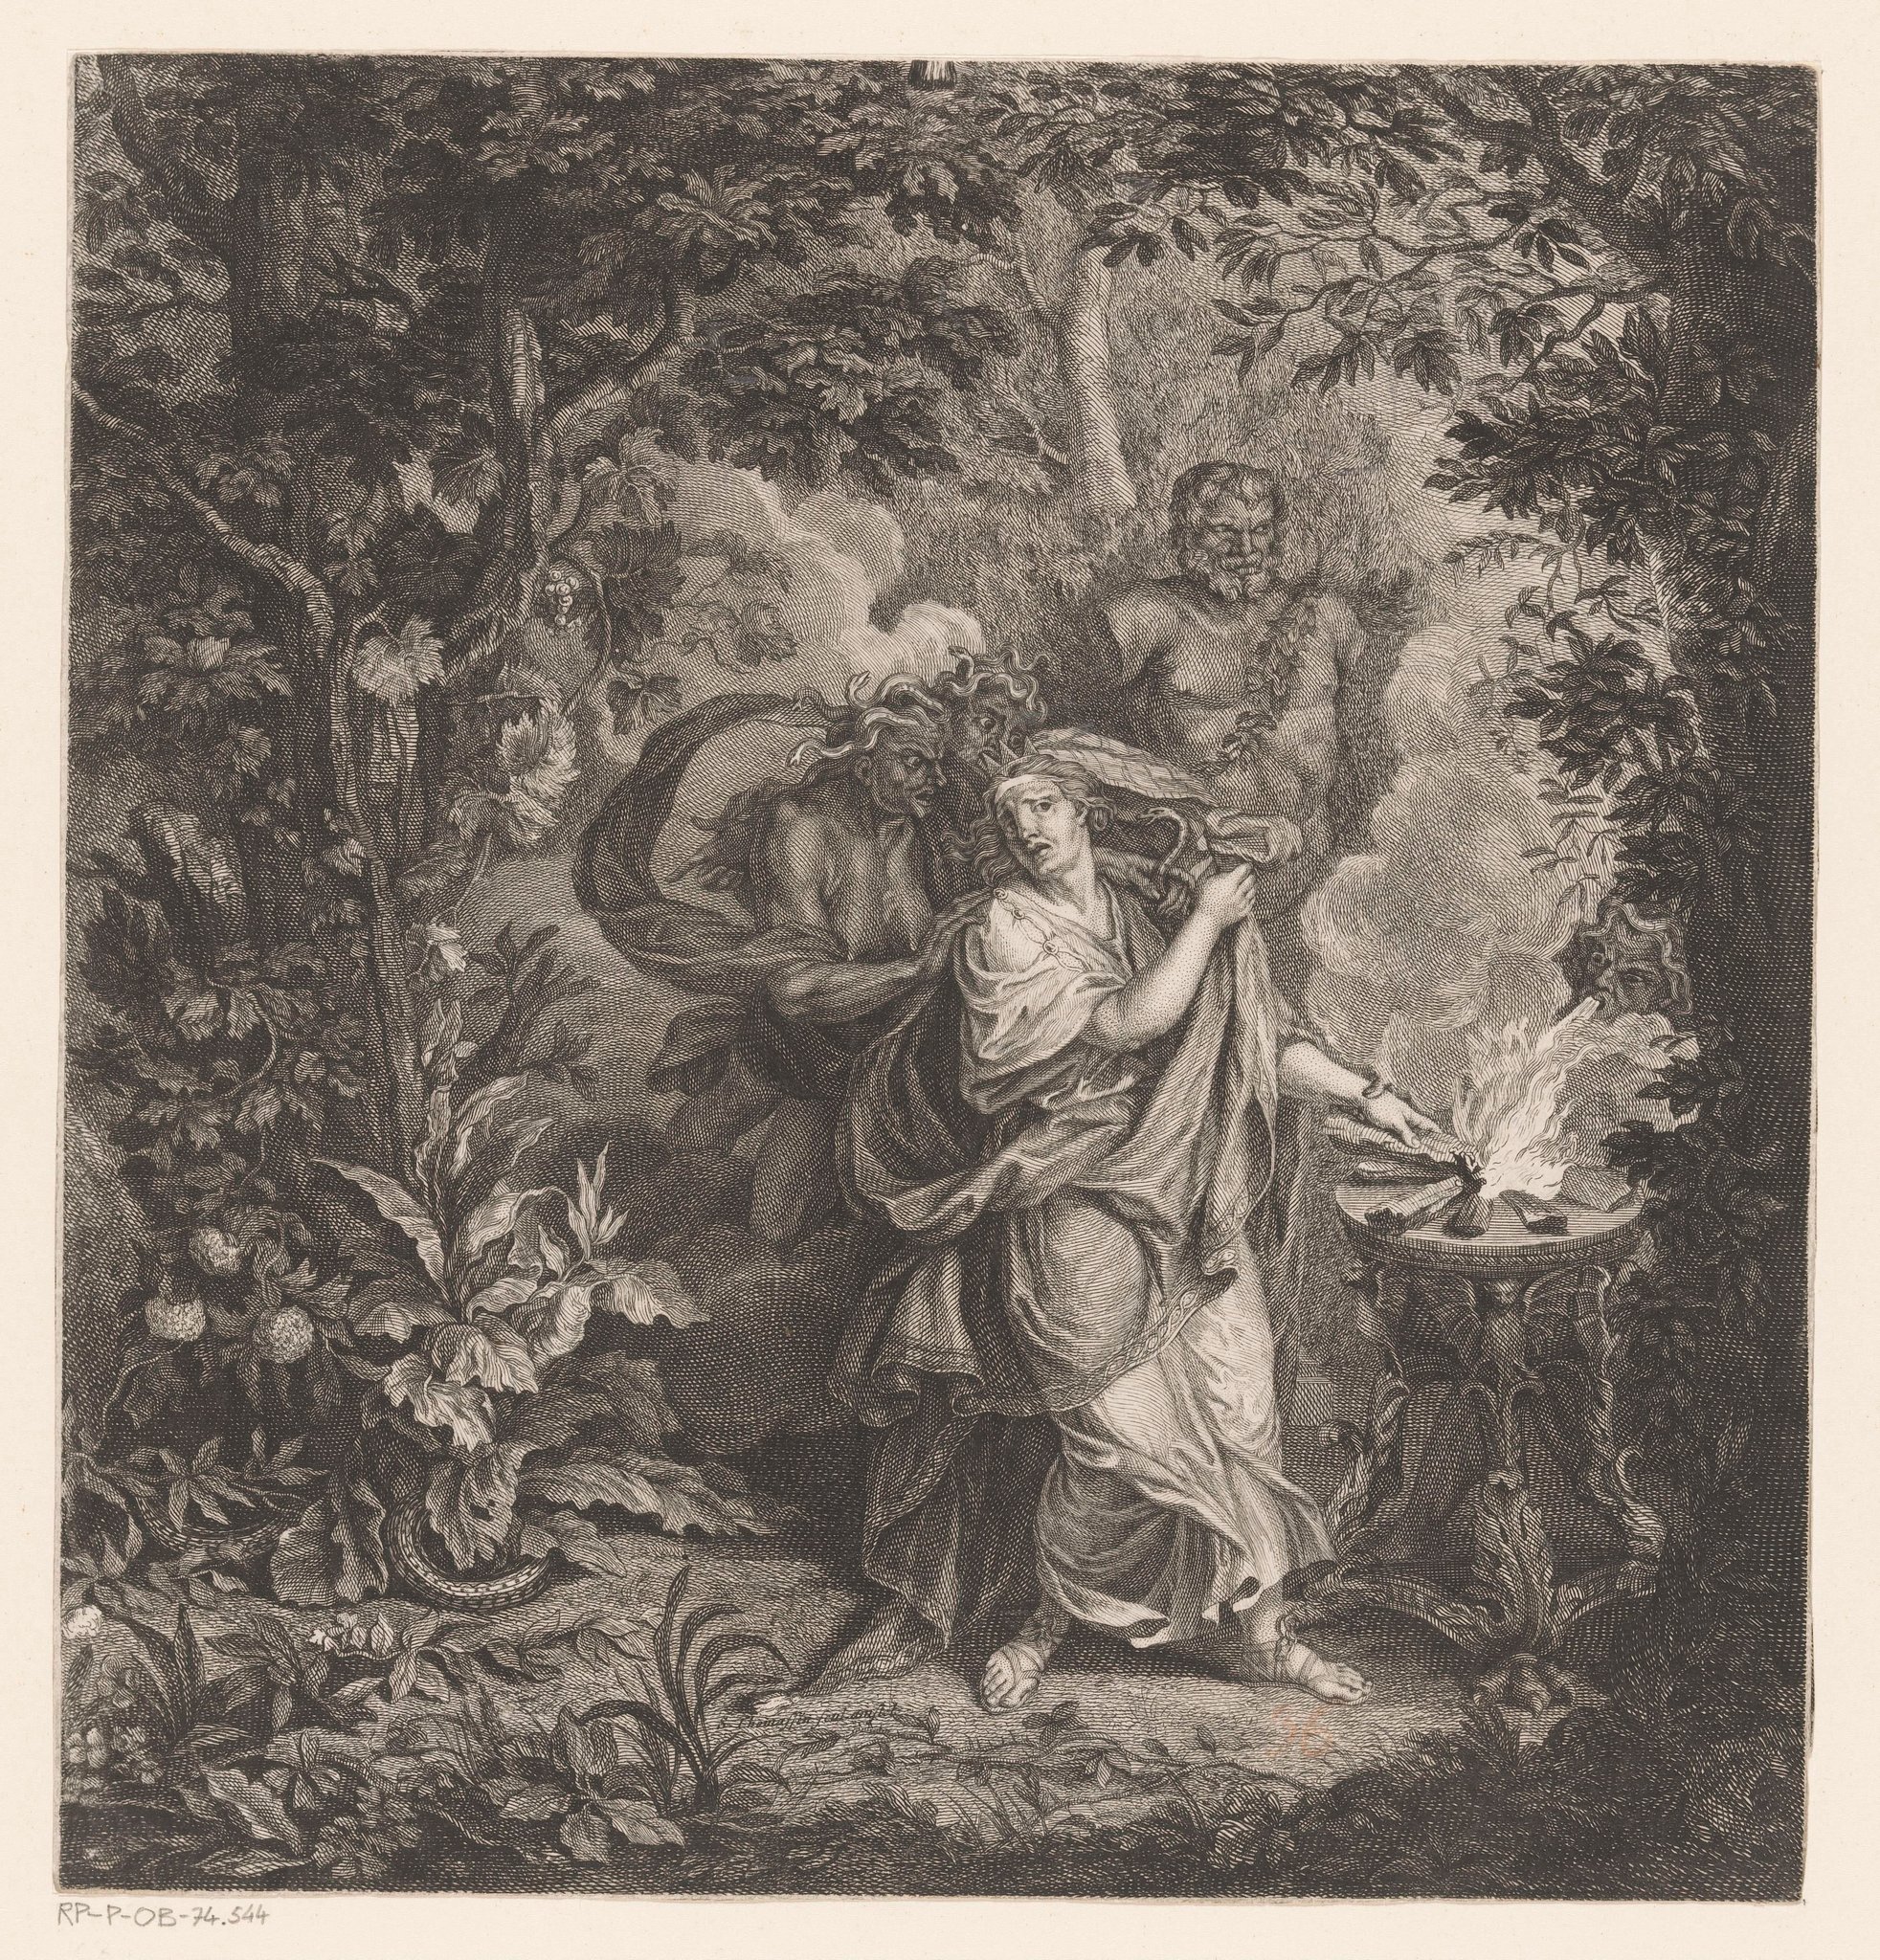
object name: print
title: Mythologische scène met een offerende koningin in een bos, mogelijk Althaea, en drie gorgonen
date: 1697-1741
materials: paper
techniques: engraving, etching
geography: amsterdam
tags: gorgons, queen, sacrifice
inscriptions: collector's mark: Lugt 240